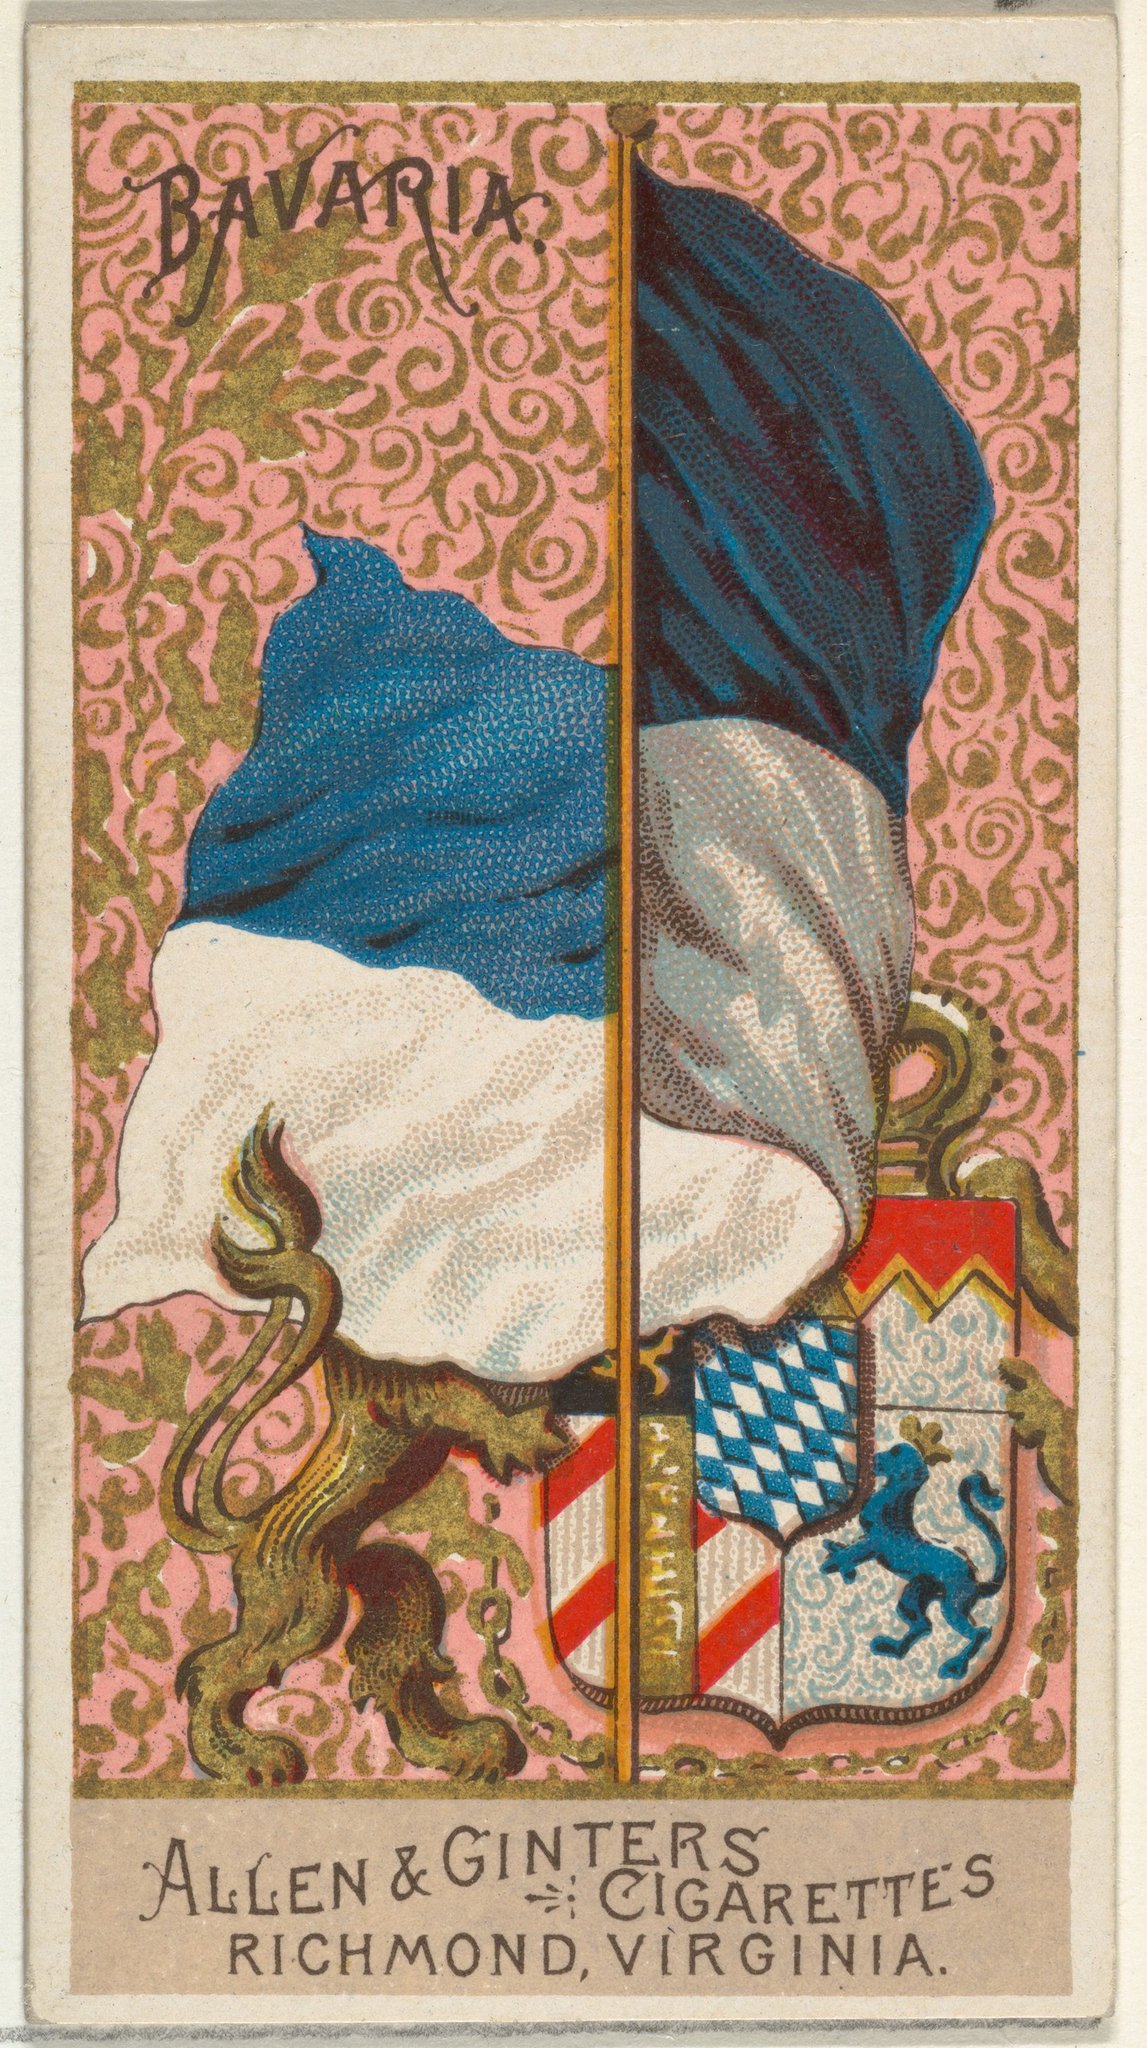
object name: print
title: Bavaria, from Flags of All Nations, Series 2 (N10) for Allen & Ginter Cigarettes Brands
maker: allen & ginter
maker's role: publisher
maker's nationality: american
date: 1890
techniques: color lithograph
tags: coat of arms,flags